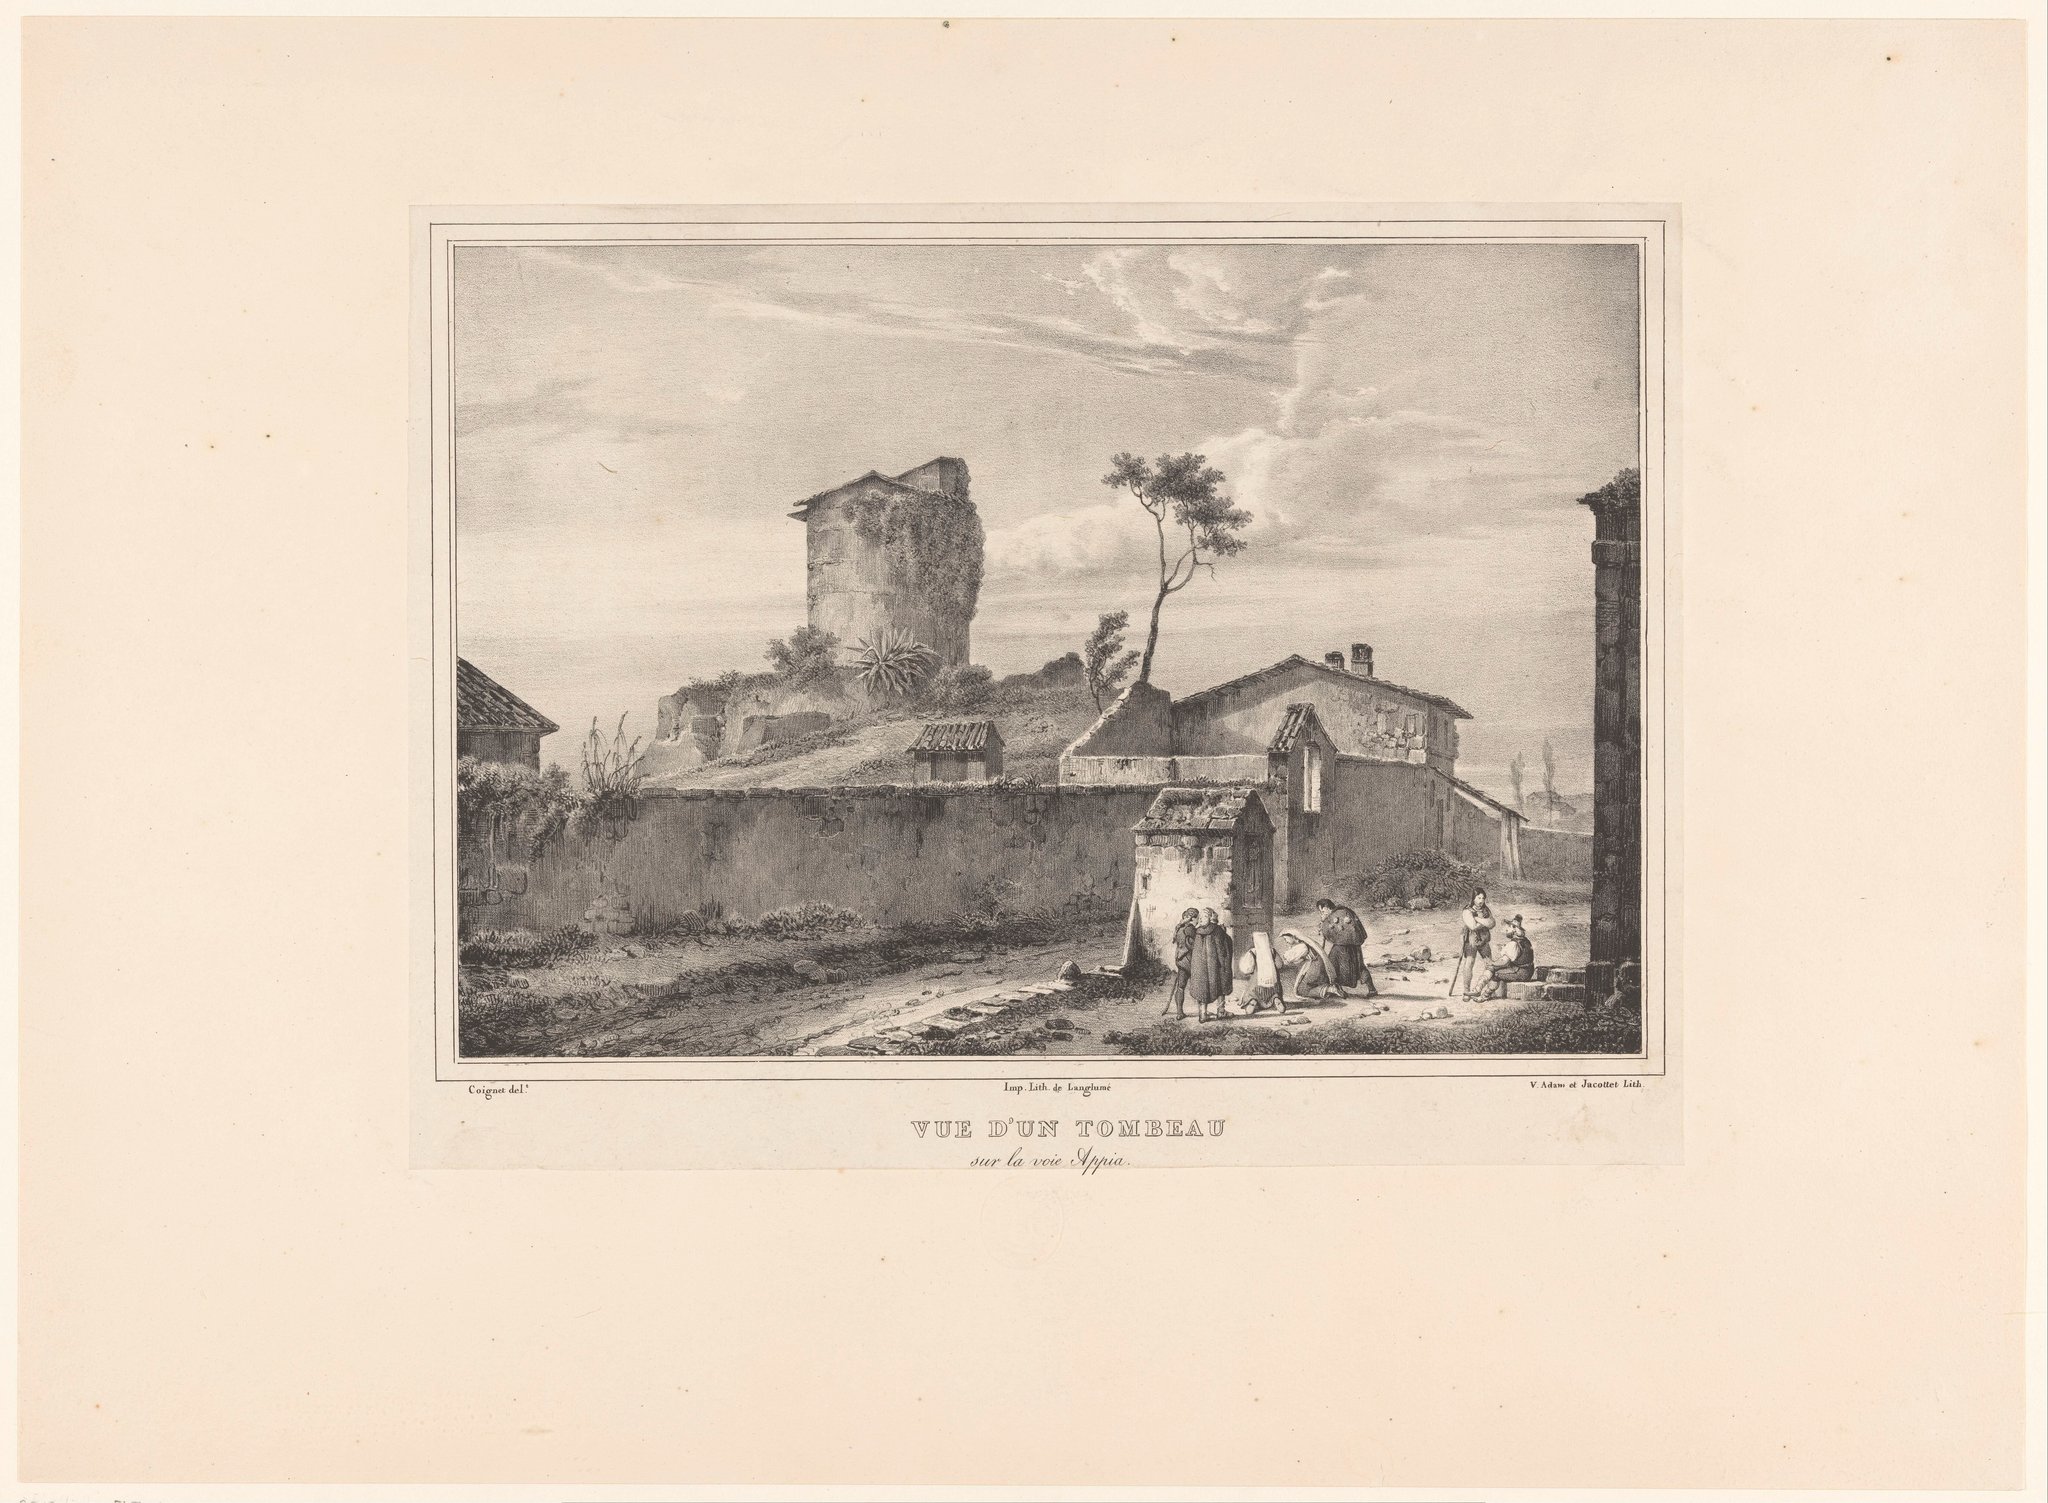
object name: print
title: Vue d'un Tombeau sur la voie Appia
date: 1824-1826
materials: paper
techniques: lithograph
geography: paris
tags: grave, tomb, 'en route', traveller under way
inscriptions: collector's mark: Lugt 2228, check stamp: Lugt 3431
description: Reizigers knielen neer bij een kapel aan de Via Appia. Achter de muur langs de weg is een grafmonument zichtbaar.